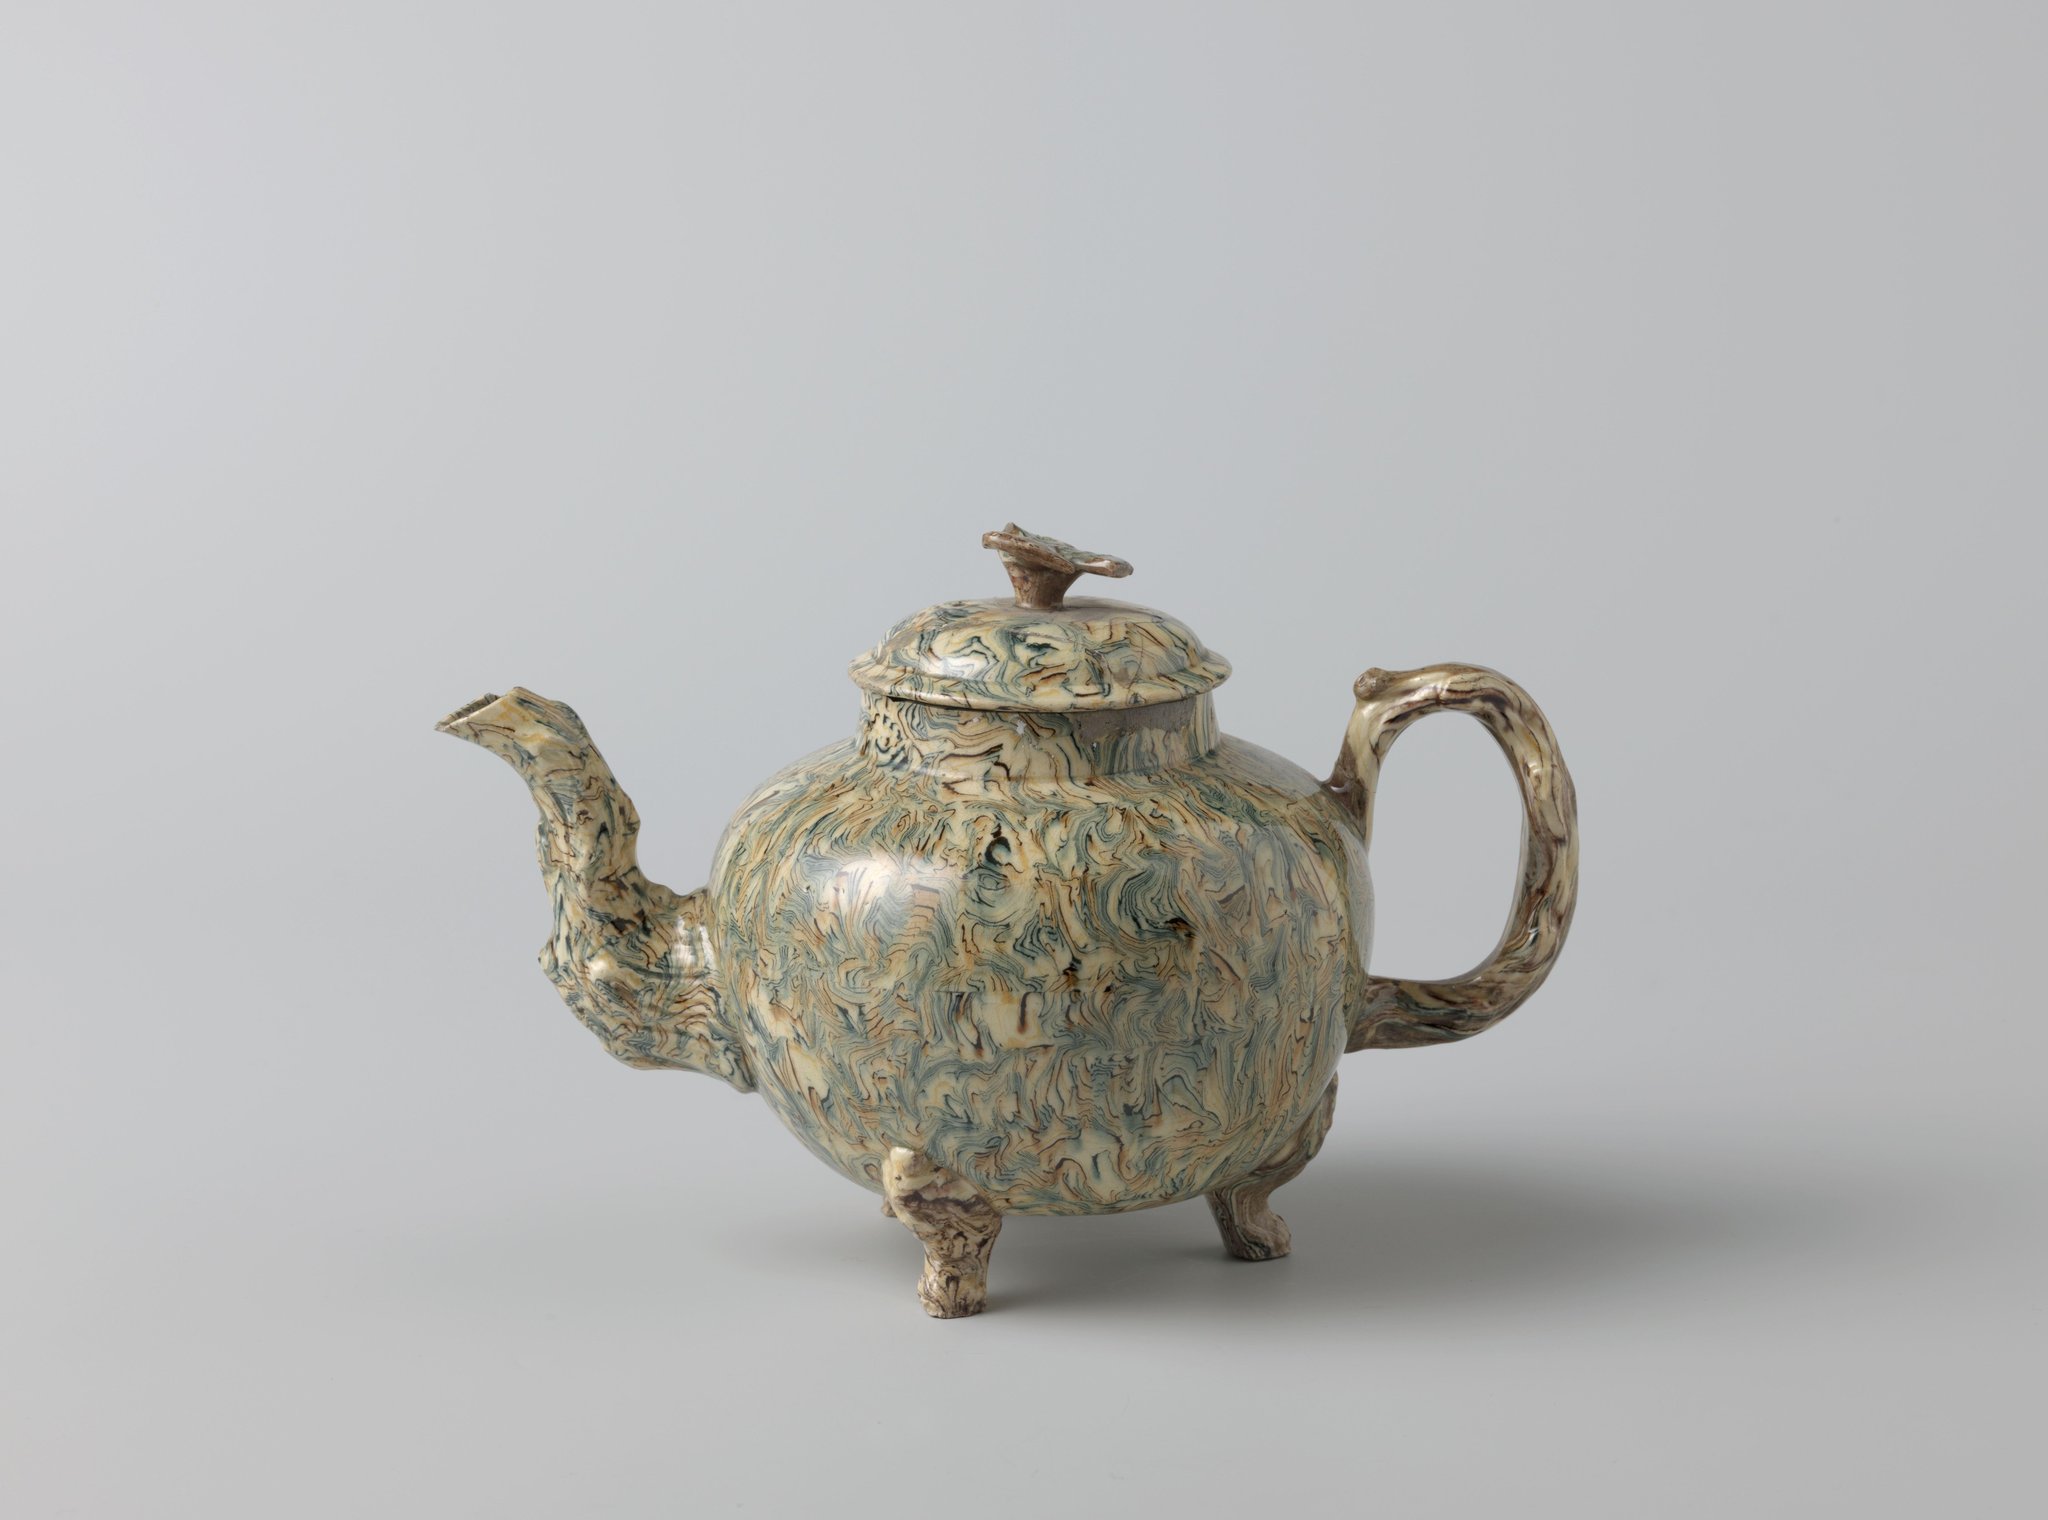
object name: pot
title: Theepot van hardgebakken aardewerk; Whieldon ware, agate ware ("kievit")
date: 1750-1765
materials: earthenware, glaze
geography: fenton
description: Bolvormige theepot van hardgebakken aardewerk. De theepot heeft een S-vormige tuit, een C-vormig oor. De pot staat op drie naar buiten gebogen poten. De theepot heeft een gemarmerd uiterlijk.